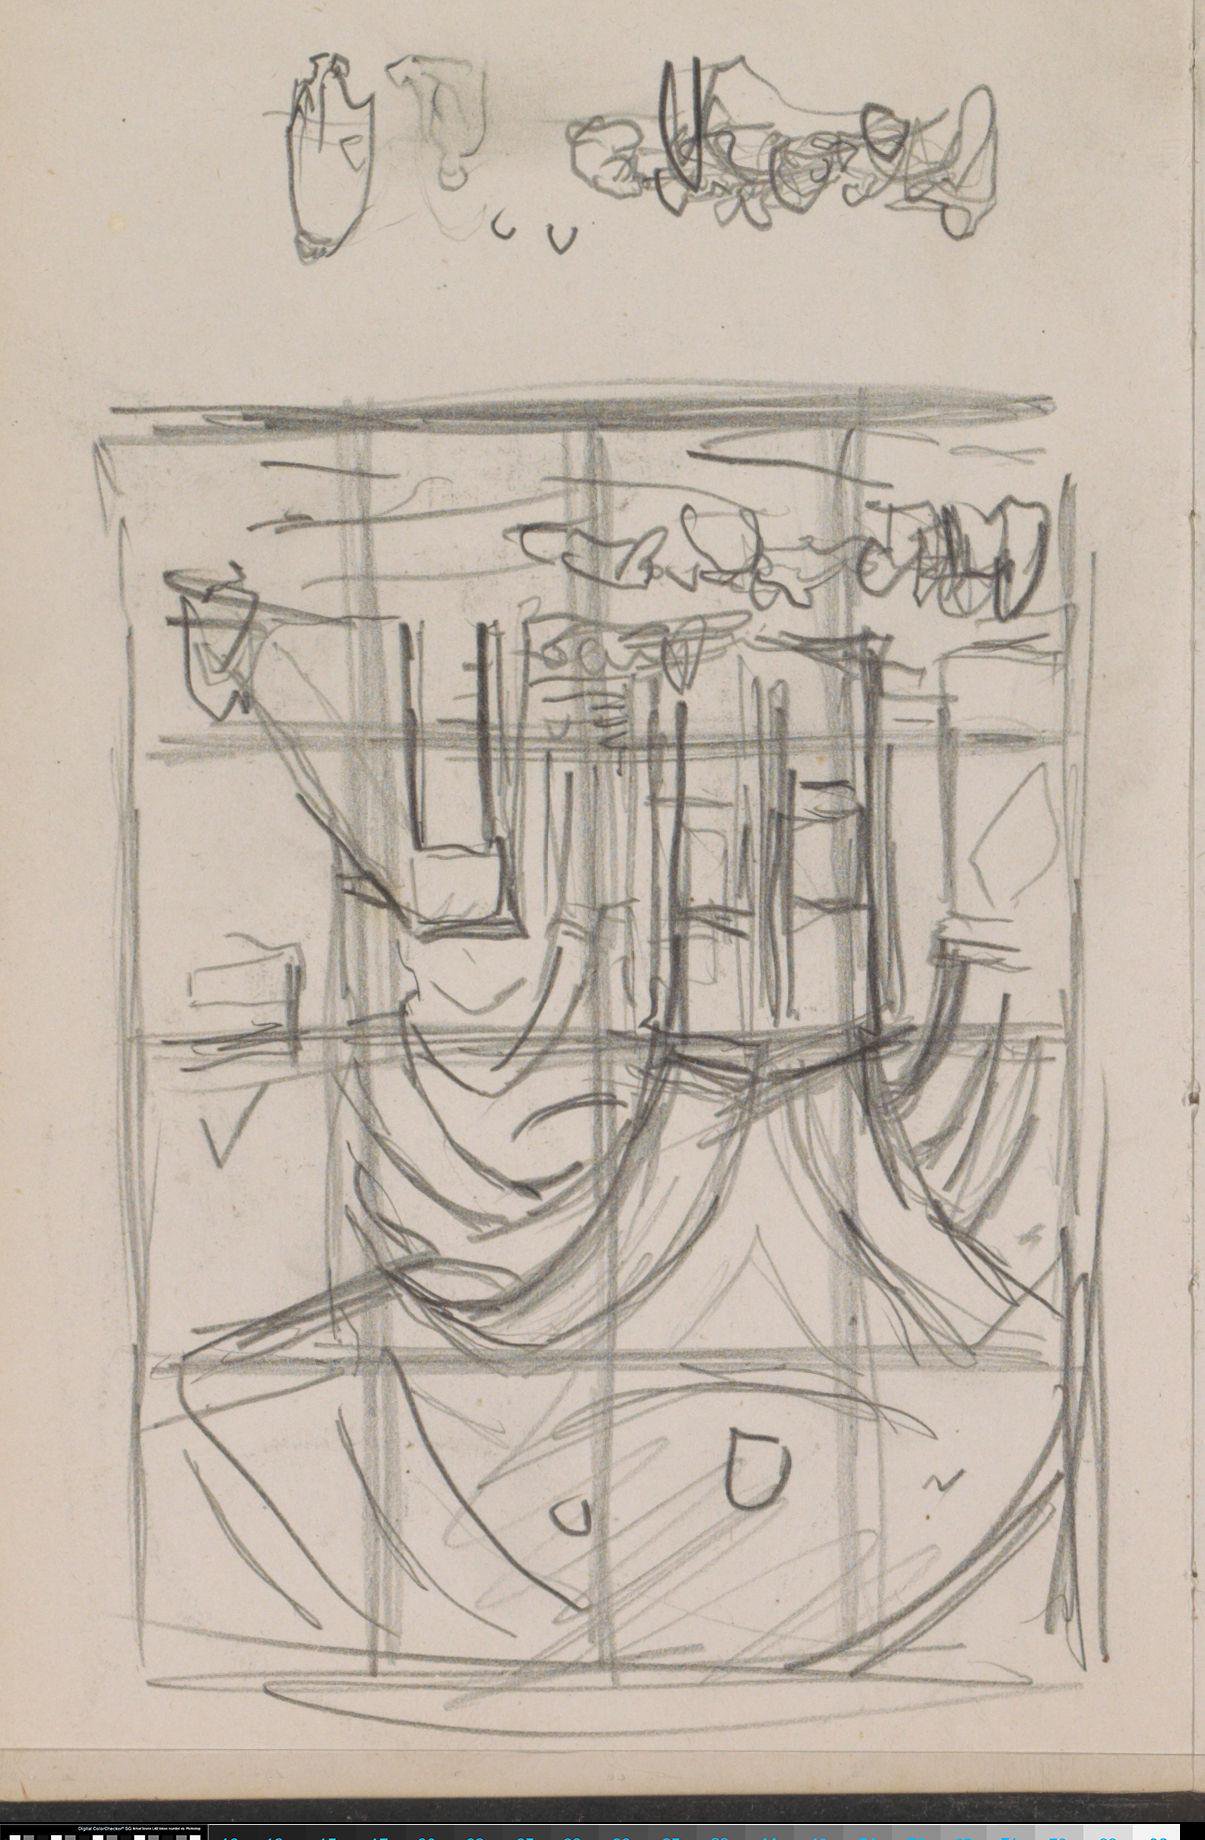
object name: sketchbook leaf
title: Interieur van een moskee en figuurstudies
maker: marius bauer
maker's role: draughtsman, print maker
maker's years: 1867-1932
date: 1896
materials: paper, pencil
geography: istanbul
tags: asiatic races and peoples, sitting figure, temple, shrine ~ islam, mohammedanism, prayer ~ islam, mohammedanism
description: Het interieur toont de minbar, of preekstoel, en enkele figuren (mogelijk in gebed) op de voorgrond. Pagina 16 uit een schetsboek met 53 bladen.